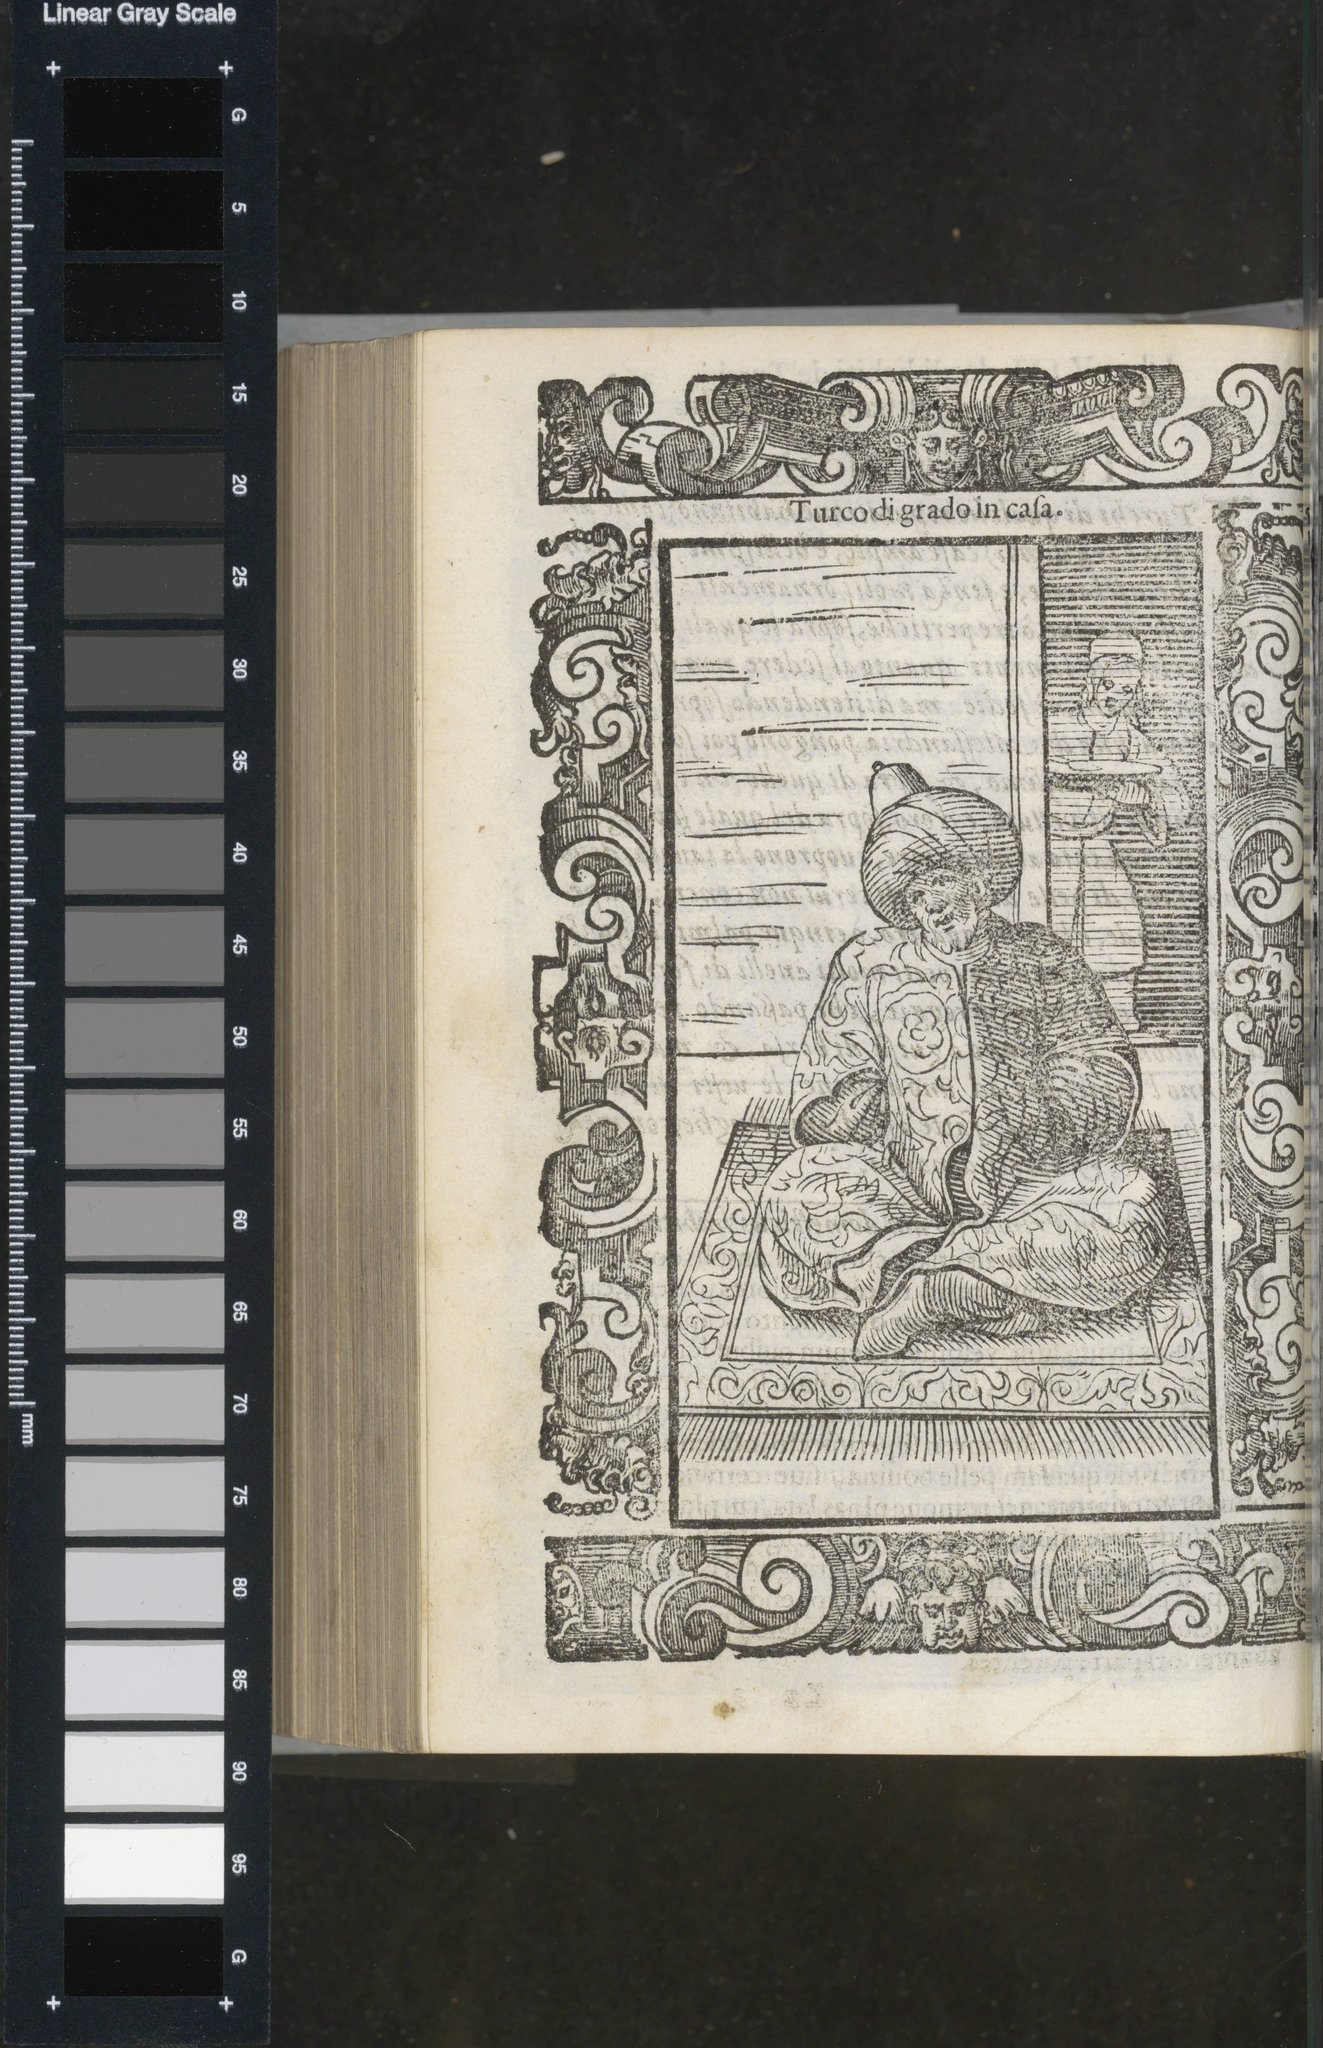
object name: costume print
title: Habiti antichi, et moderni di tutto il mondo...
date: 1598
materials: paper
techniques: woodcut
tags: fashion plates